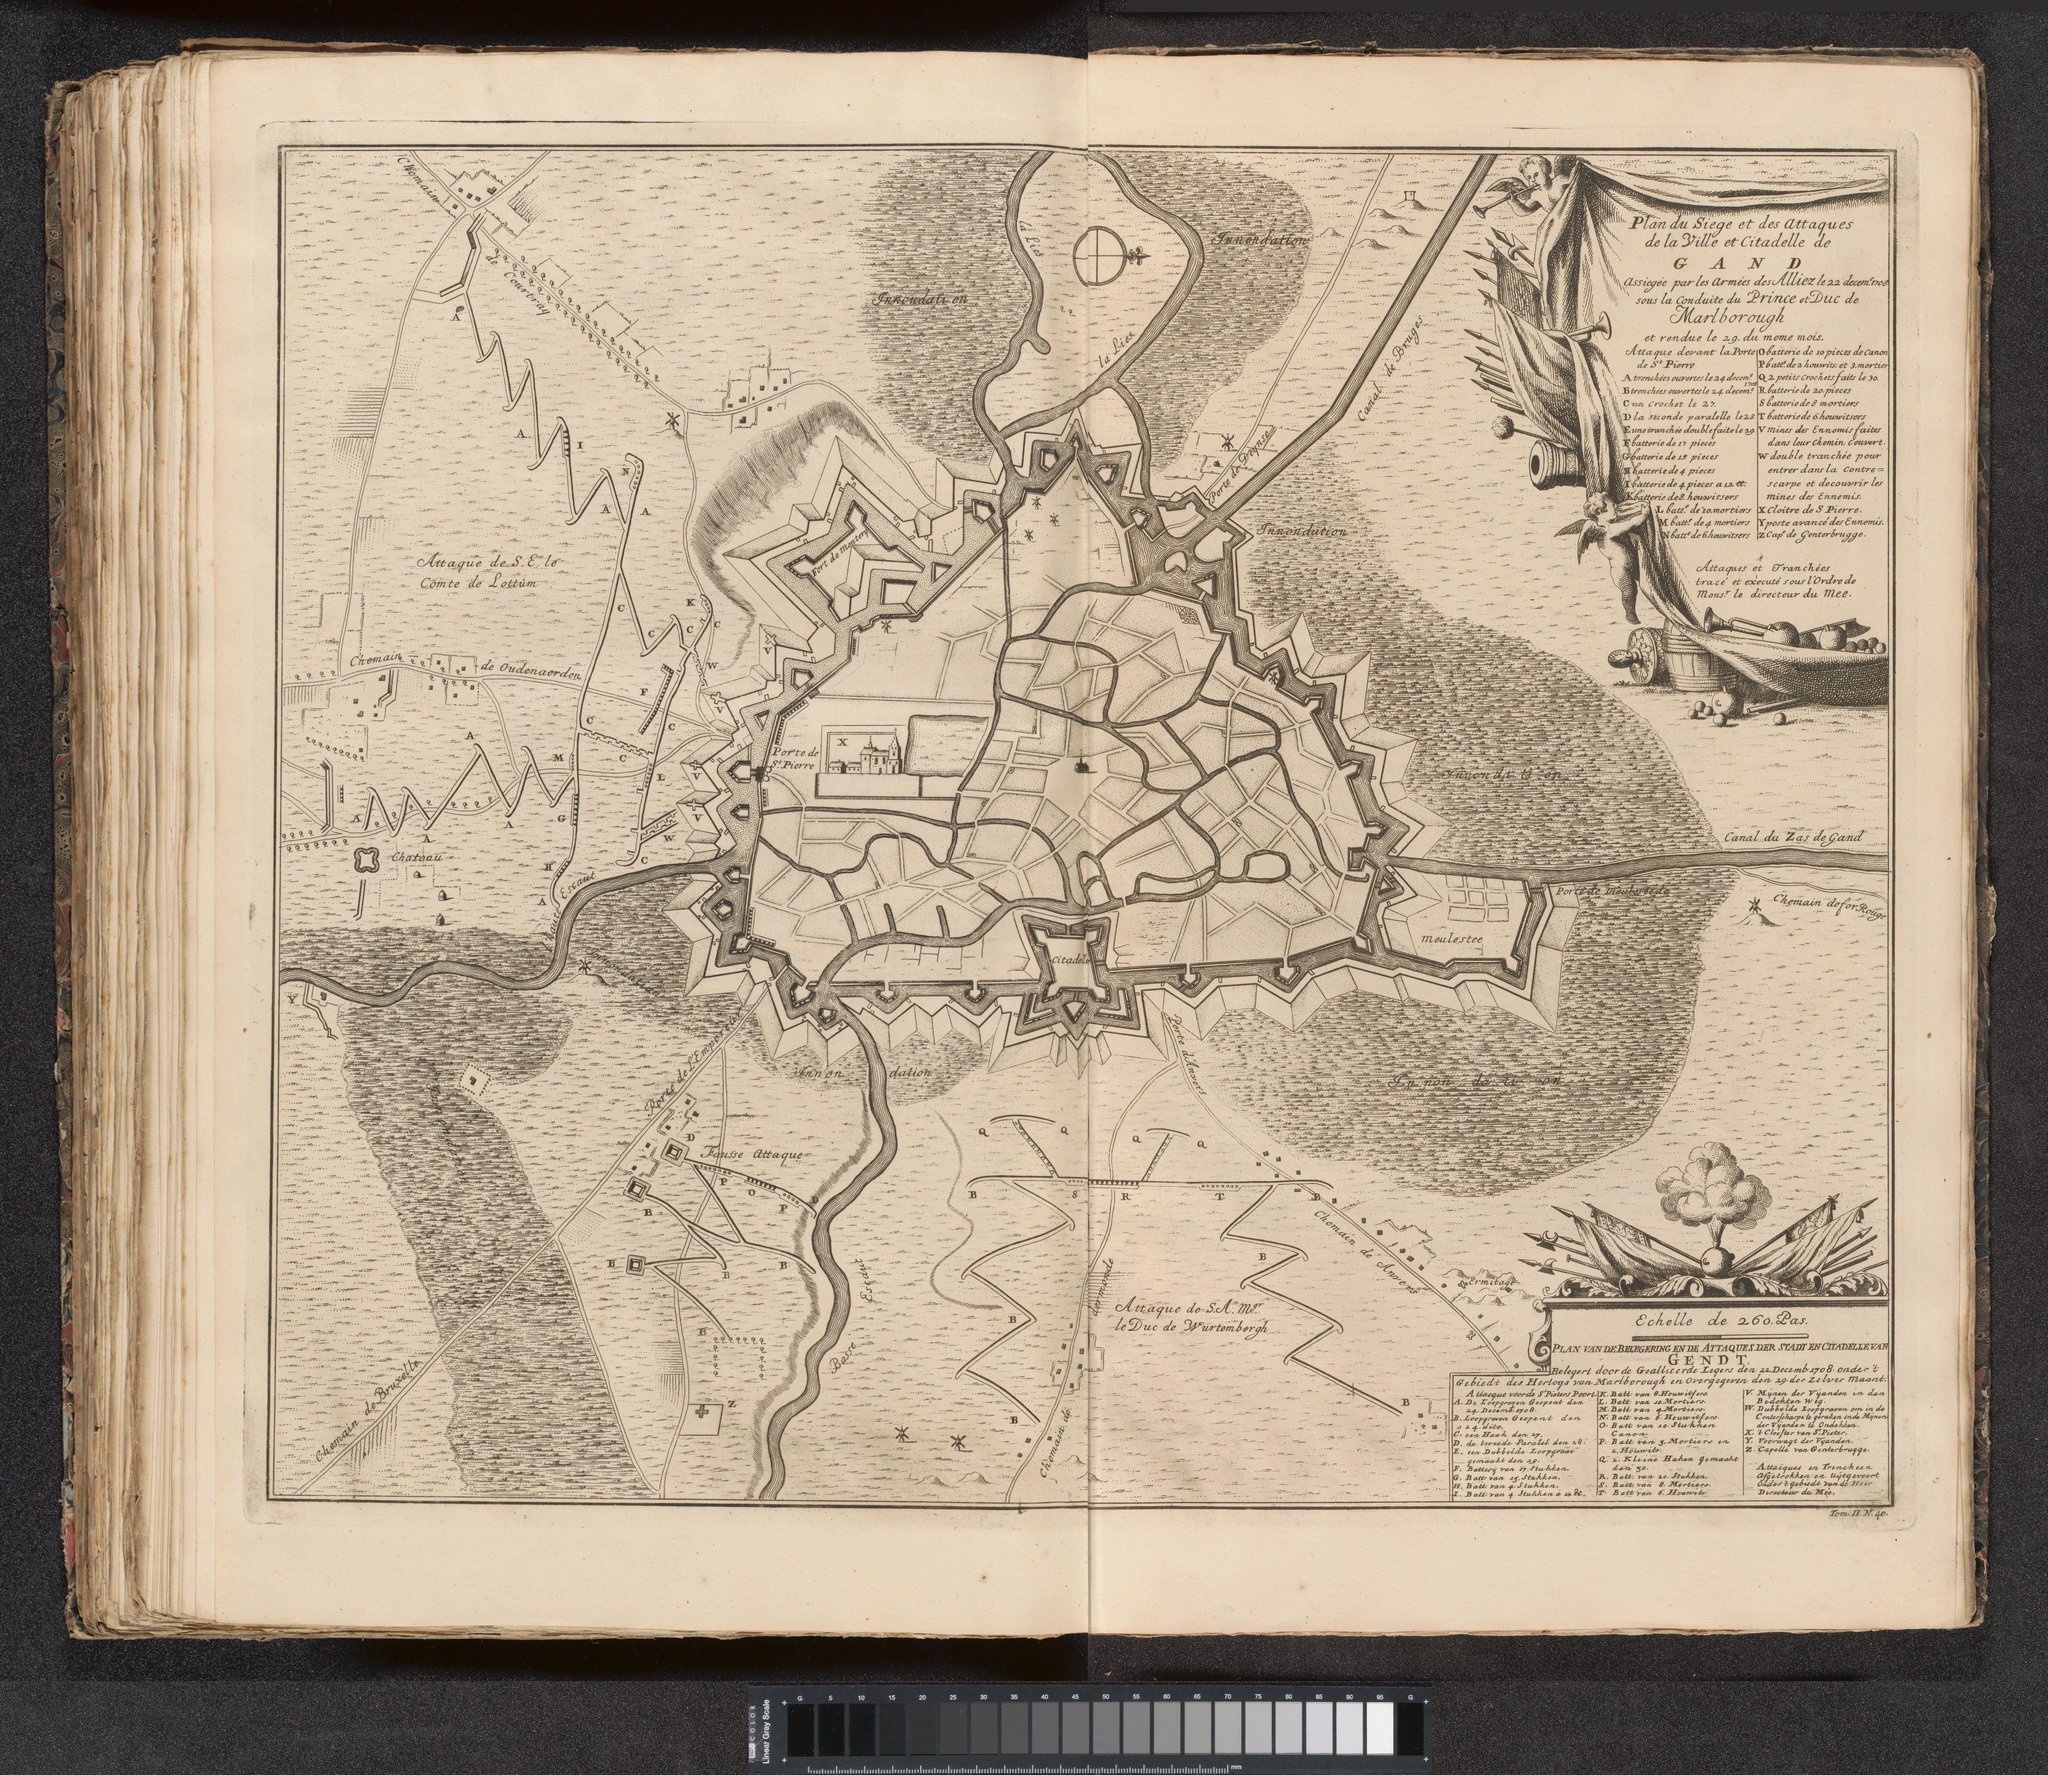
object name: map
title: Plan du Siege et des Attaques de la Ville et Citadelle de Gand (...) / Plan van de Belegering en de Attaques der Stadt en Citadelle van Gendt, Belegert door de Geallieerde Legers den 23. Decemb; 1708 onder 't Gebiedt des Hertogs van Marlborough en Overgegeven den 29. der Zelver Maant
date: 1708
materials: paper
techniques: etching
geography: northern netherlands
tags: johan willem friso (prins van oranje-nassau), john churchill (1e hertog van marlborough), fortress, maps of cities, ghent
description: Plattegrond van Gent, belegerd vanaf 23 december door de geallieerden onder de hertog van Marlborough en ingenomen op 29 december 1708. Genummerd rechtsonder: Tom. II. No. 40. Illustratie in het tweede deel van : [Jean] du Mont, Oorlogskundige beschryving van de veldslagen en belegeringen, der drie ... wydvermaarde krygsoversten... den Prins Eugenius van Savoye, den ... Hertog van Marlborough, en den Prins van Oranje en Nassau-Vriesland, in de editie van 1729. Dit tweede deel is hoofdzakelijk gewijd aan de daden van de hertog van Marlborough en prins Johan Willem Friso.